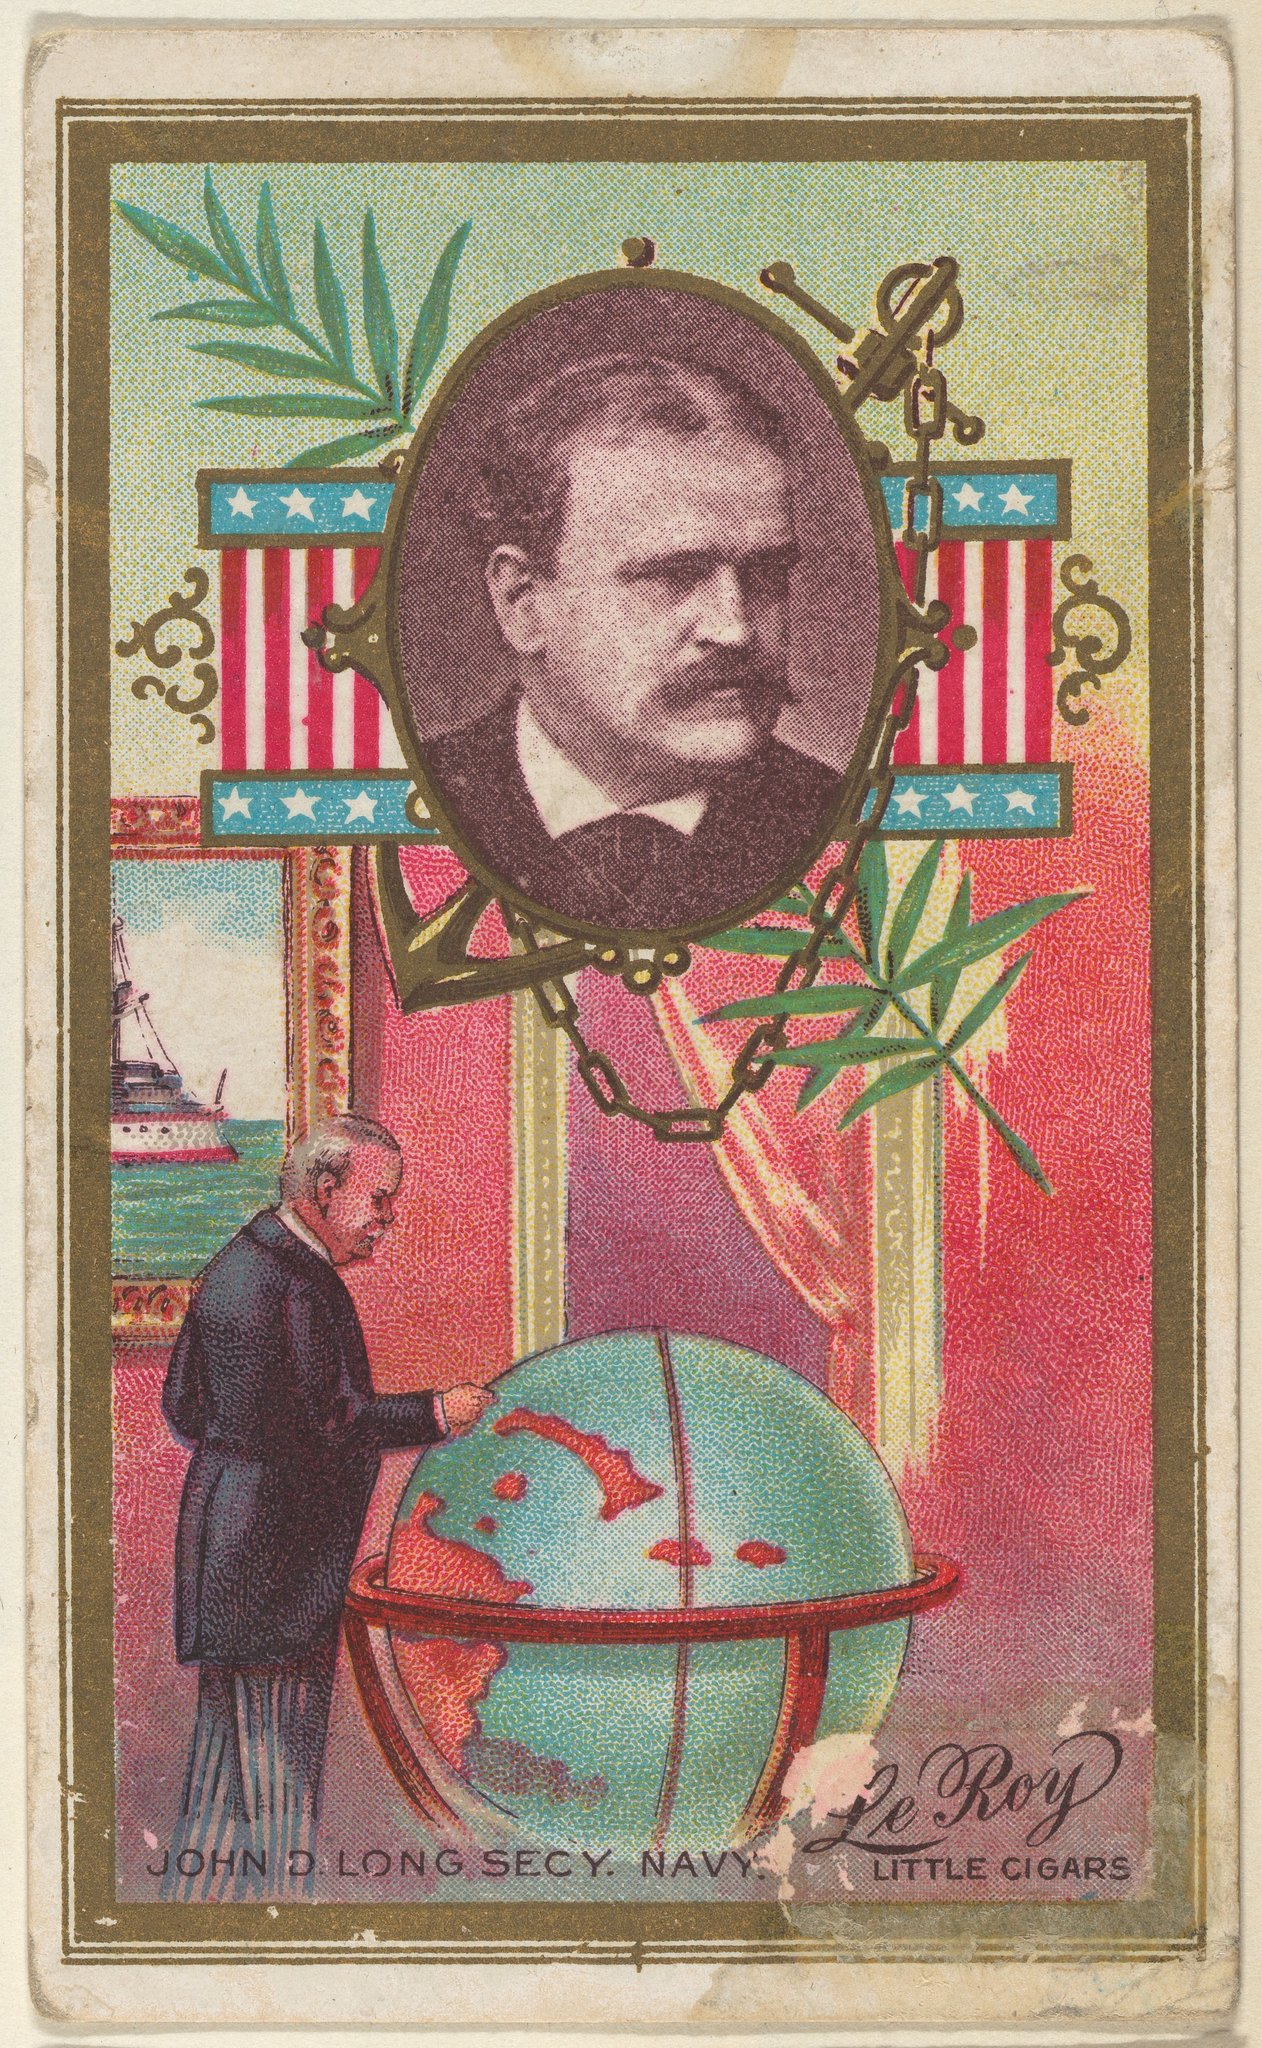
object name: print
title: John D. Long, Secretary, U.S. Navy, from the "Generals" series (T63), issued by LeRoy Little Cigars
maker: leroy little cigars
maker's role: publisher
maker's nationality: american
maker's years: 1850-1950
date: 1898-1901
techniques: color lithograph